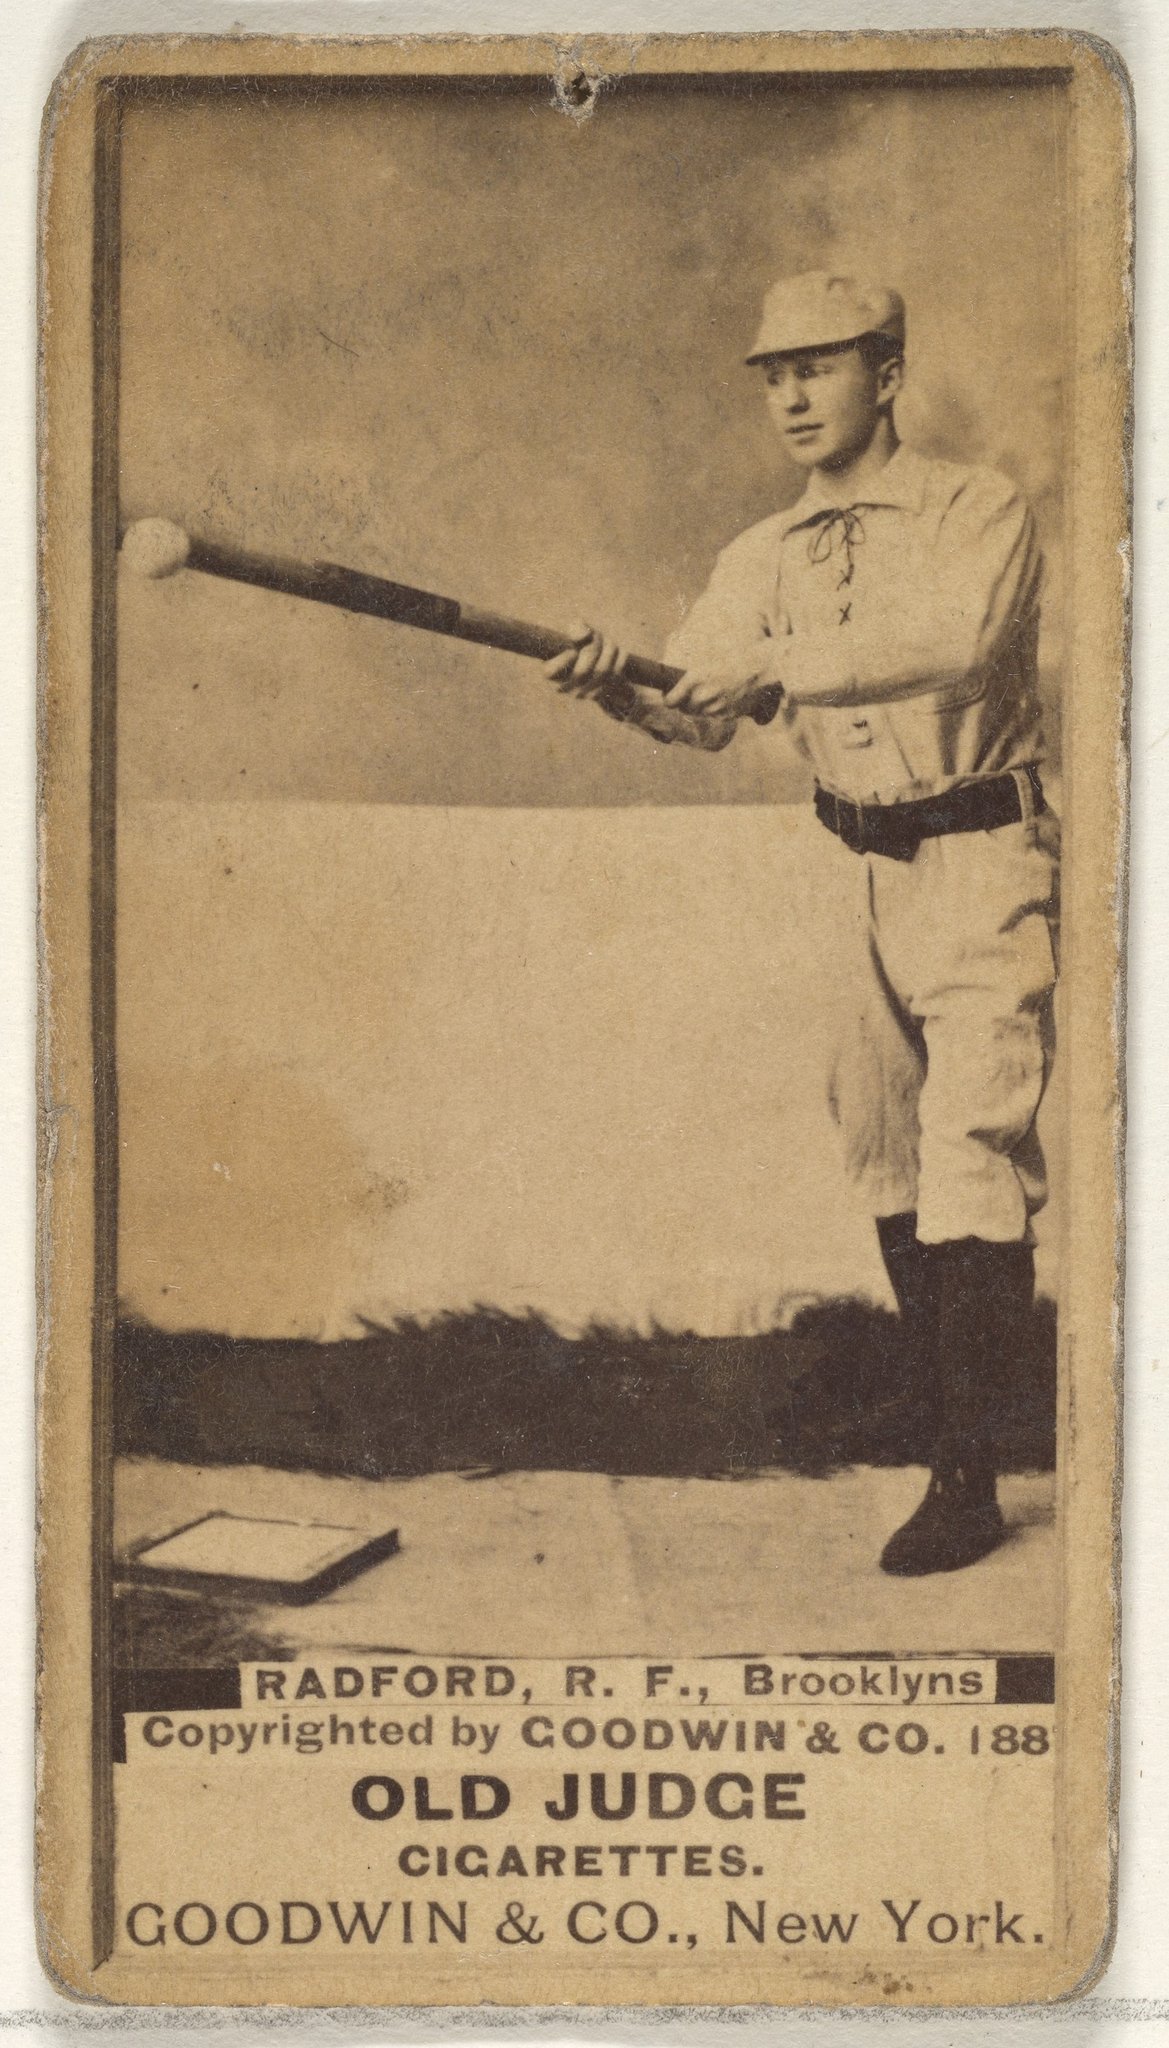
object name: baseball card, photograph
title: Radford, Right Field, Brooklyn Bridegrooms, from the Old Judge series (N172) for Old Judge Cigarettes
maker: goodwin & company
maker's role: publisher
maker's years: 1850-1950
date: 1888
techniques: albumen silver print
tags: men,portraits,baseball,athletes